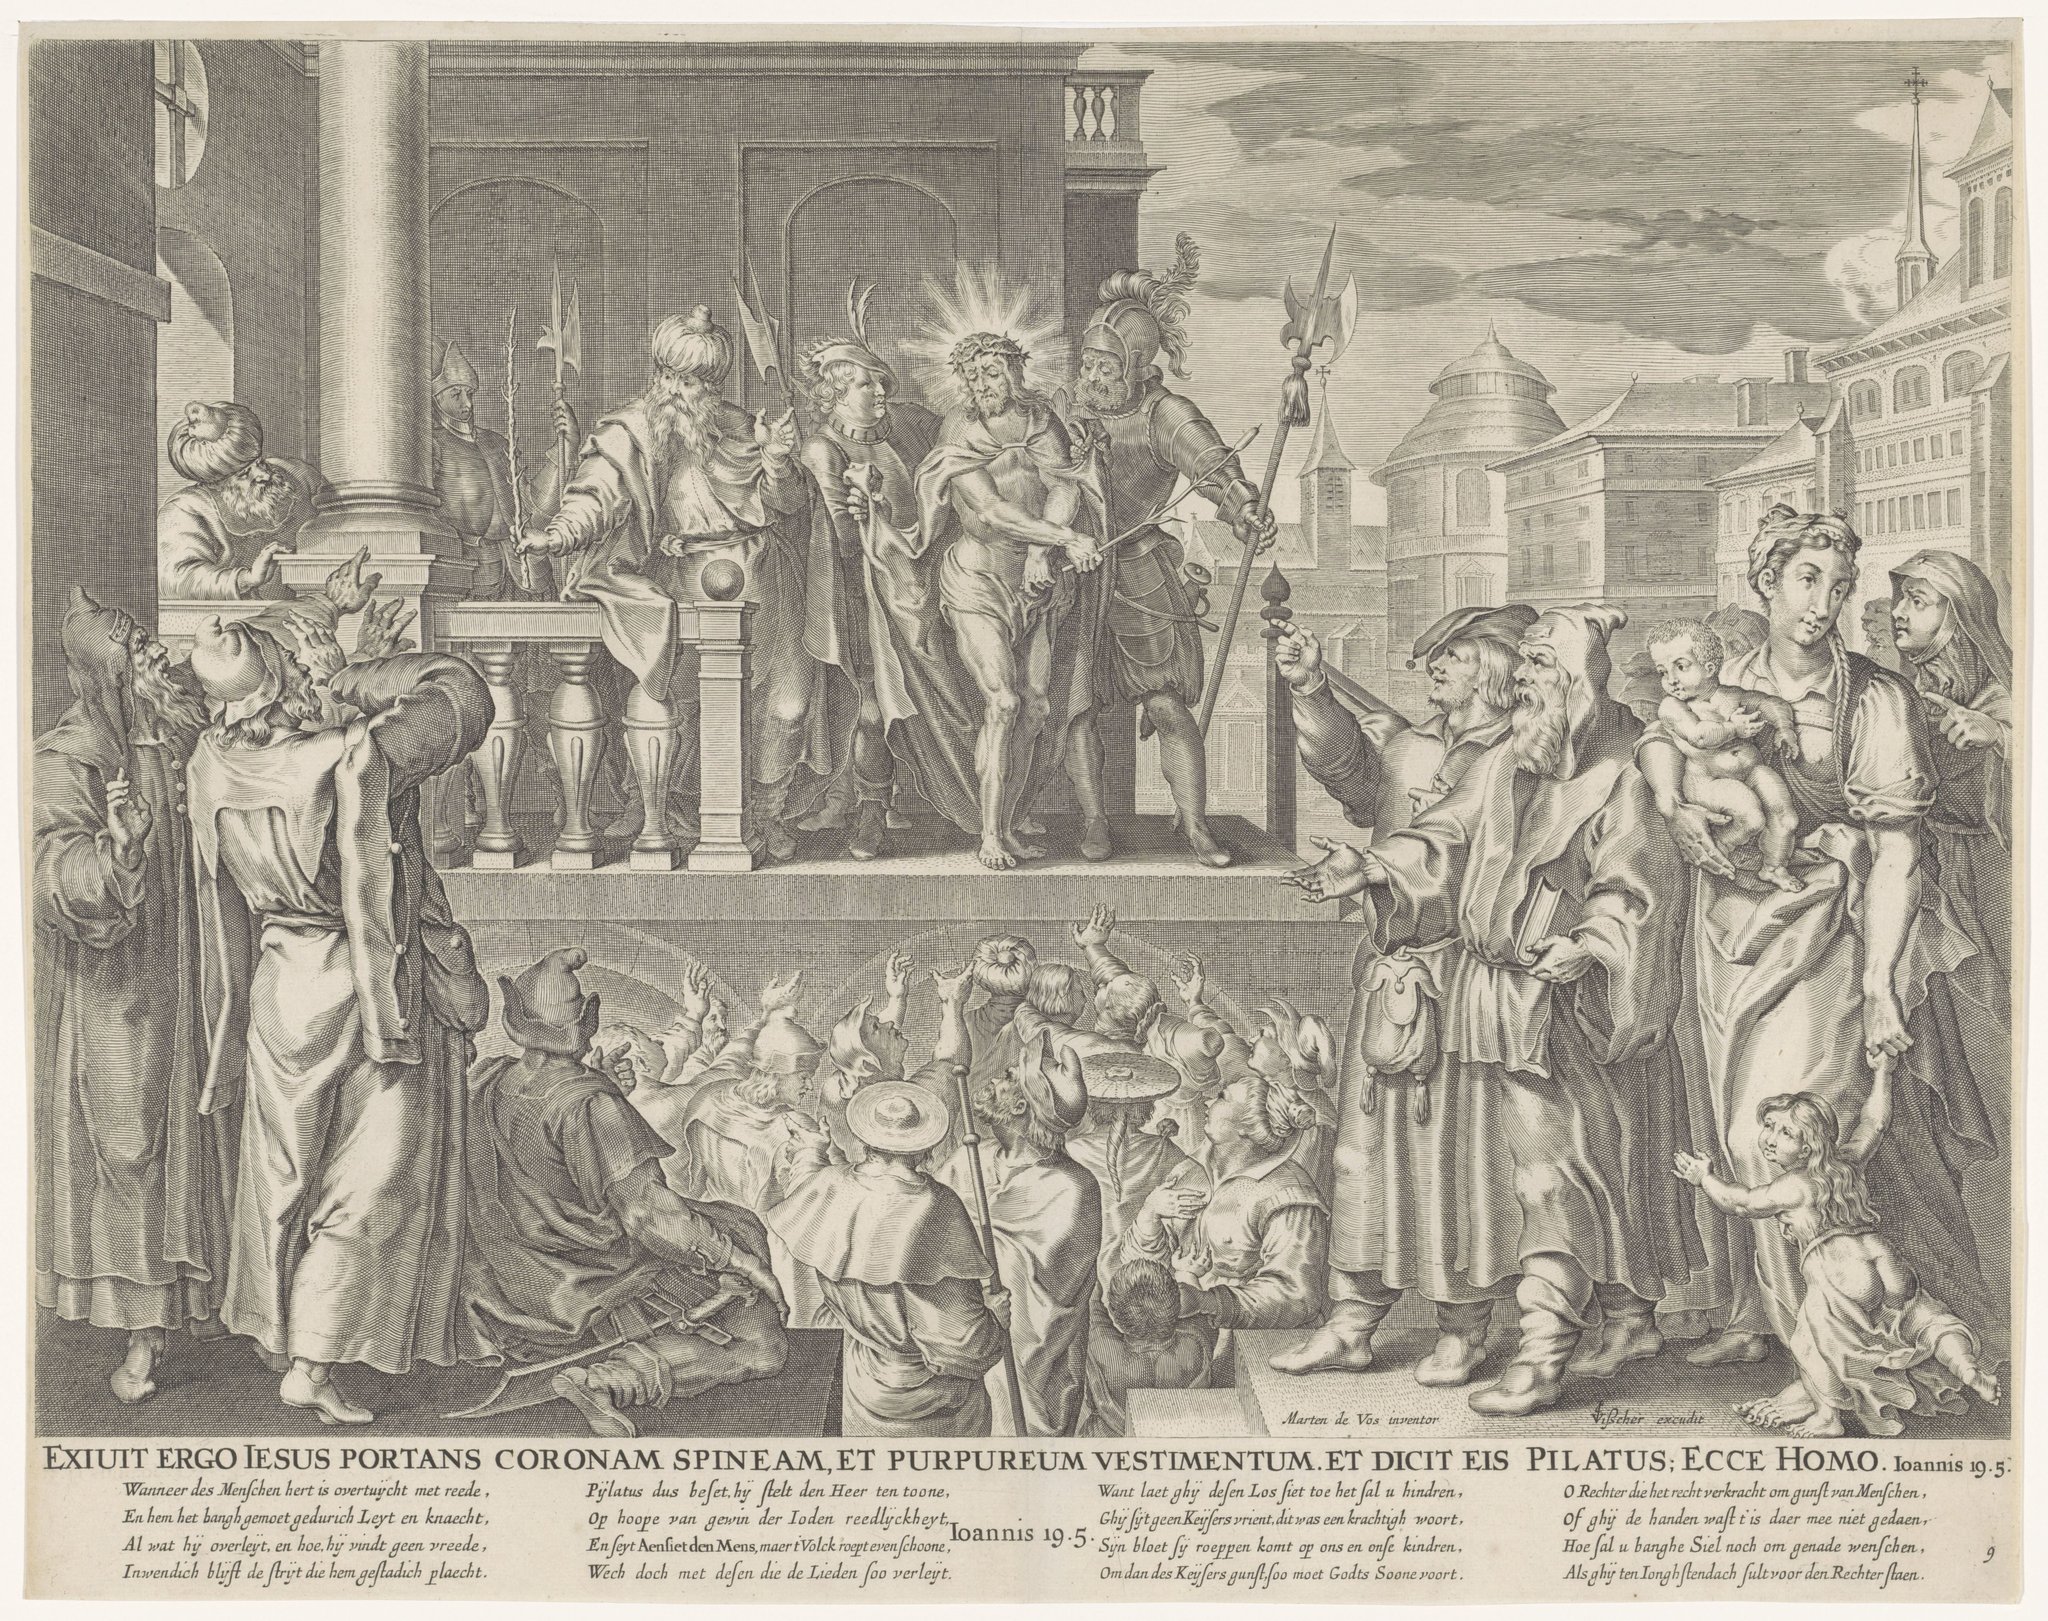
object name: print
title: Christus aan het volk getoond (Ecce Homo)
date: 1630-1652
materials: paper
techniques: engraving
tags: carrying a child on the hip, astride, crowd, mob, pilate showing christ to the people, 'ostentatio christi', 'ecce homo' (john 19:4-6)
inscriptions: collector's mark: Lugt 2228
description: De Amsterdamse uitgever Claes Jansz. Visscher (II) produceerde vanaf de jaren ’30 van de zeventiende eeuw grote Bijbelse prenten op zogenaamd royaal-formaat papier (ca. 480 x 580 mm). Na zijn dood in 1652 zette zijn zoon Nicolaes Visscher (I) het bedrijf voort en zo ook de uitgave van Royaalbijbelprenten. Toen Nicolaes in 1679 overleed nam zijn zoon Nicolaes Visscher (II) het bedrijf over en gaf kort hierna, omstreeks 1680, een fondslijst uit. Hierin worden 130 prenten met Bijbelse voorstellingen op royaalpapier beschreven (zie documentatie J. van der Waals). Complete prentbijbels op royaal-formaat werden door vader en zoon Nicolaes Visscher uitgegeven onder de titel Historiae Sacrae Veteris et Novi Testamenti. De bladen werden echter ook los verkocht en konden worden gecombineerd met Royaalbijbel-prenten van andere uitgevers. Verschillende Amsterdamse uitgevers brachten namelijk ook bijbelprenten op royaal-formaat uit, onder wie Clement de Jonghe en Cornelis Danckerts. De door de firma Visscher uitgegeven prenten zijn veelal vervaardigd door anonieme prentmakers naar voorbeeld van verschillende zestiende- en zeventiende-eeuwse Bijbelse prenten en prentreeksen. Veelal moesten de composities worden aangepast aan het grotere en langgerekte royaal-formaat. Daarnaast zijn er ook grote bladen van bekende prentmakers zoals Jan van Londerseel, Pieter Nolpe, Jacques de Gheyn (II) en Jan Harmensz. Muller opgenomen in de categorie ‘Bybelsche Figuren, op Royaal-bladen’ in de fondslijst van Visscher. Prent mogelijk gebruikt in: Historiae Sacrae Veteris et Novi Testamenti (Royaalbijbel). Amsterdam: Nicolaes Visscher (I) en (II), [1652-1702]. In de fondslijst van Nicolaes Visscher II (ca. 1680) is het onderwerp van deze prent onder de titel 'Bybelsche Figuren, op Royaal-bladen. bestaande uyt de volgende historien.' als volgt genummerd: 113.